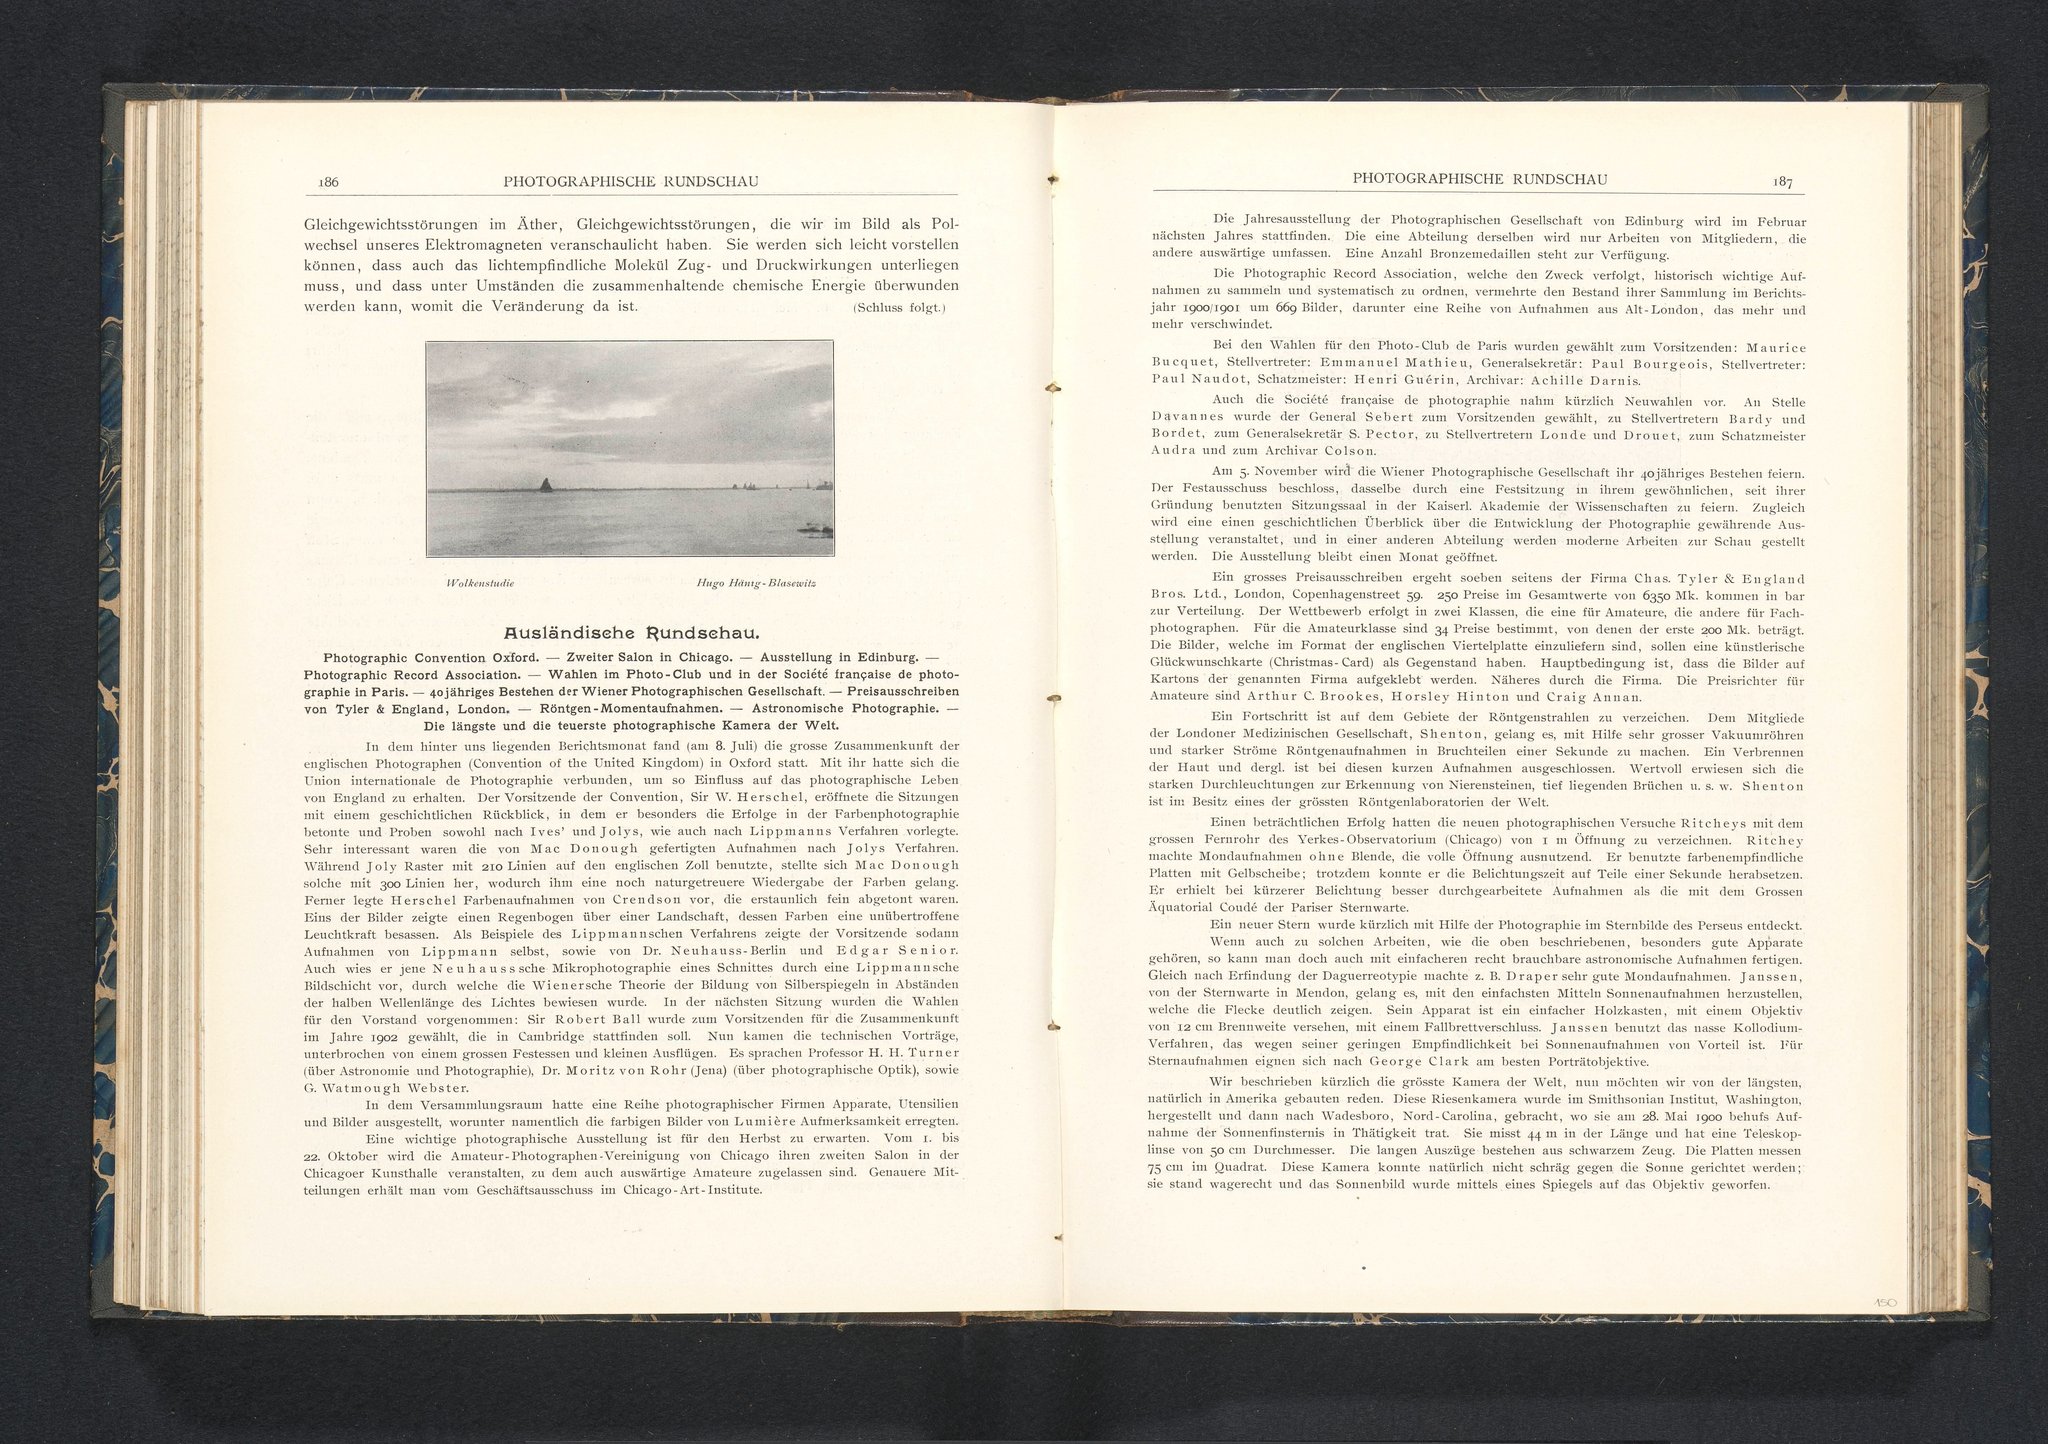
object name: photomechanical print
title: Zeelandschap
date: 1896-1901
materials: paper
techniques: autotype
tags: sea (seascape)